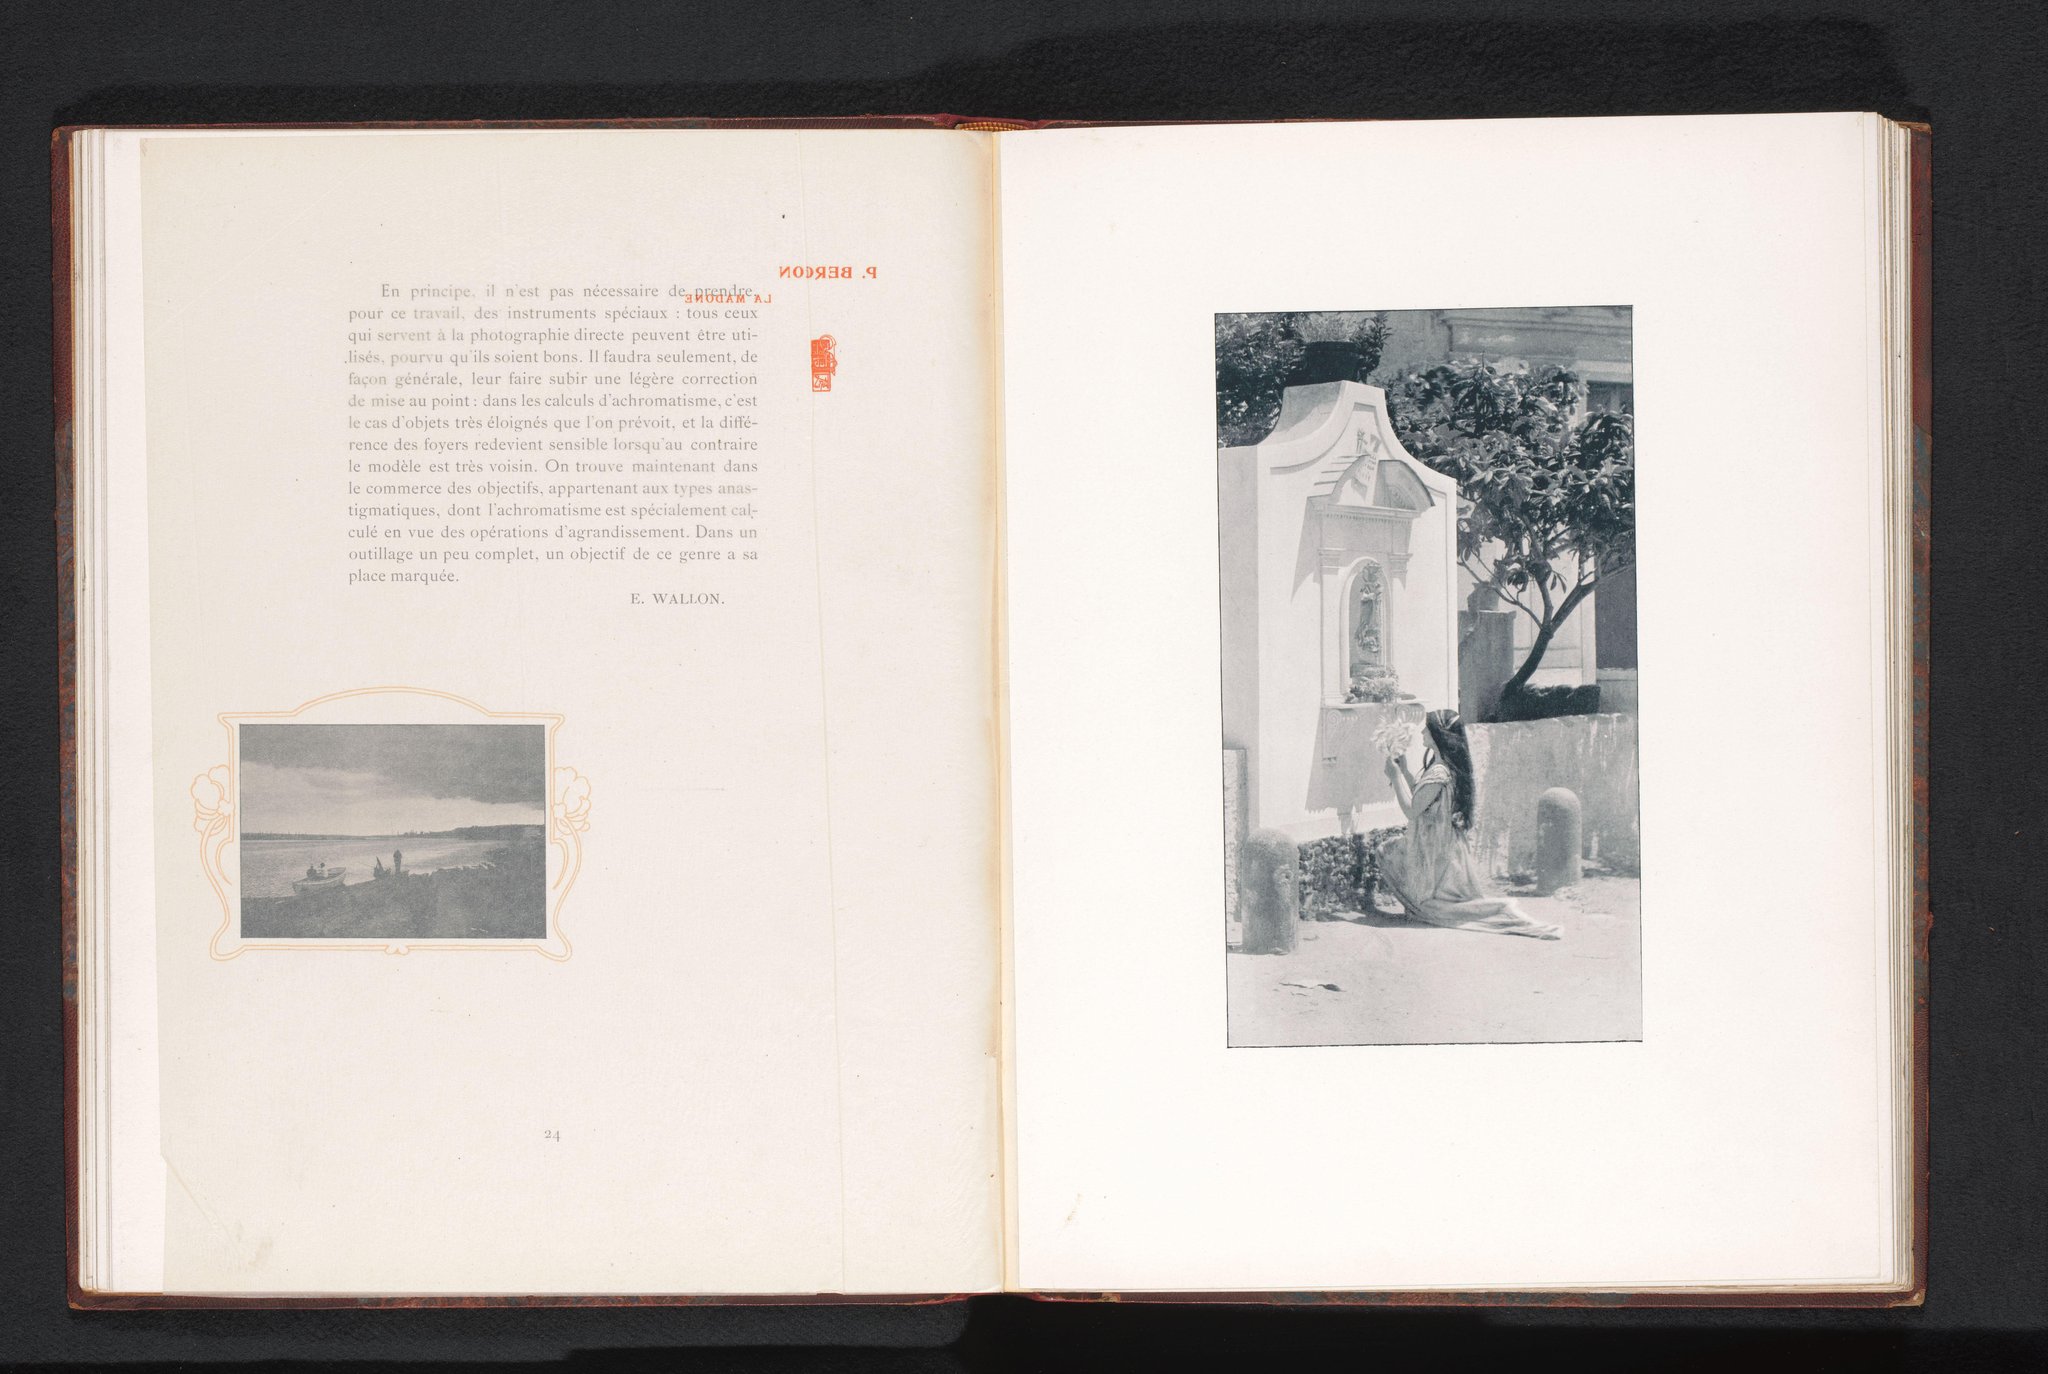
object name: page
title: Vrouw bidt voor een Mariabeeld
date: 1895-1900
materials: paper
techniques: autotype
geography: brussels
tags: the virgin mary, one person praying